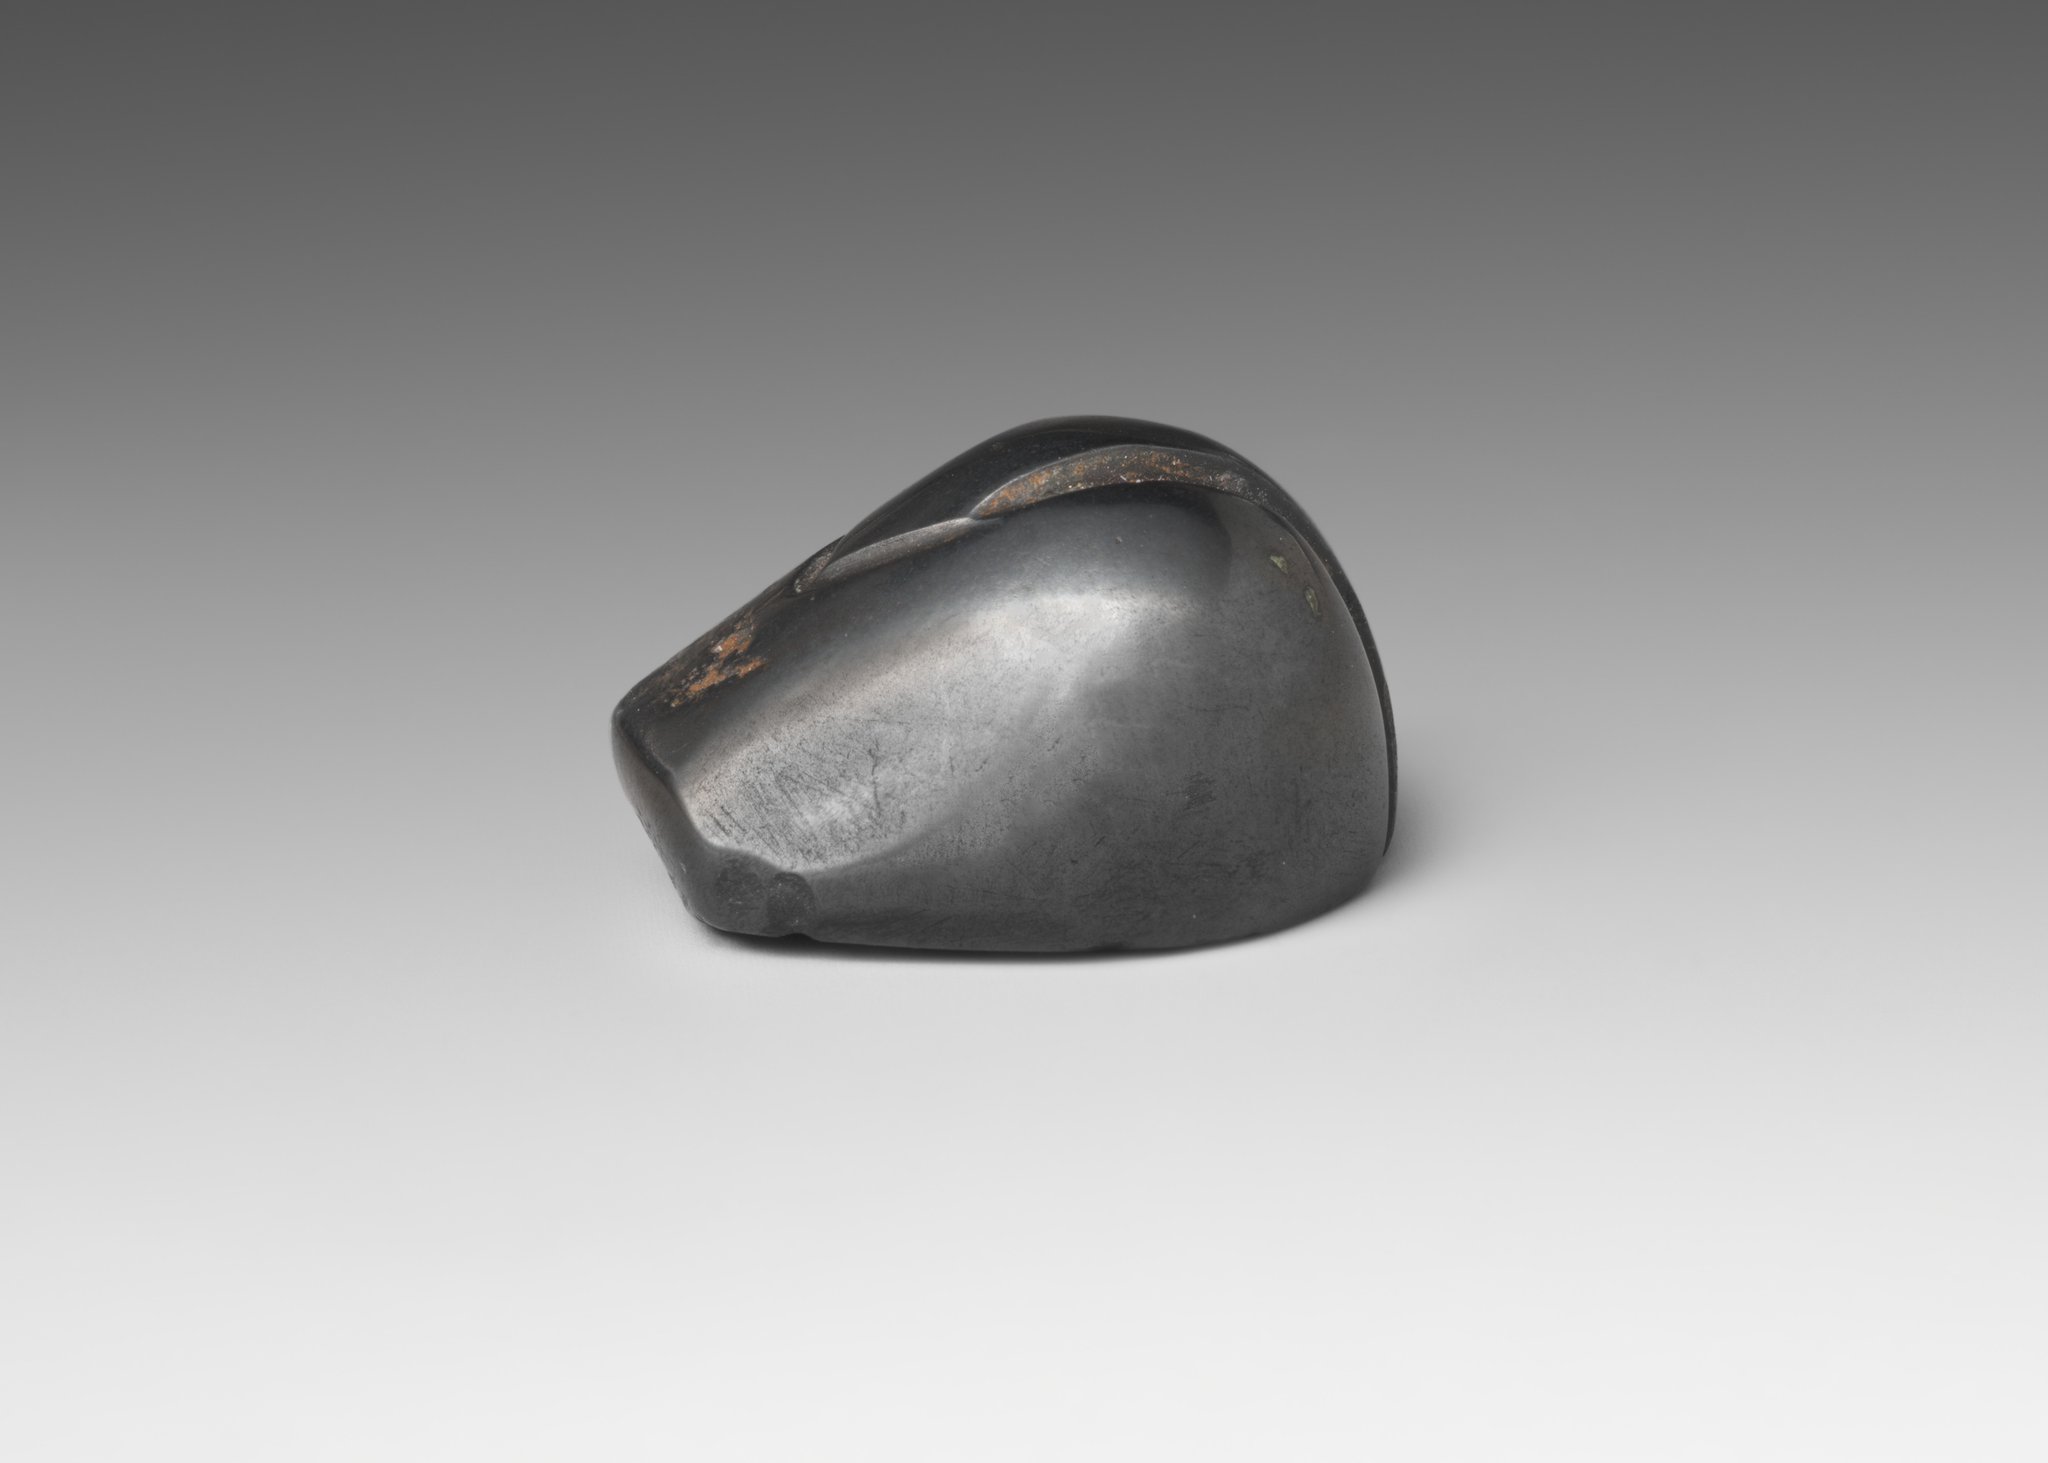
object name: weight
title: Weight in the shape of a duck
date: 2000-1001 BCE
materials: mineral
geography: cyprus or western asia